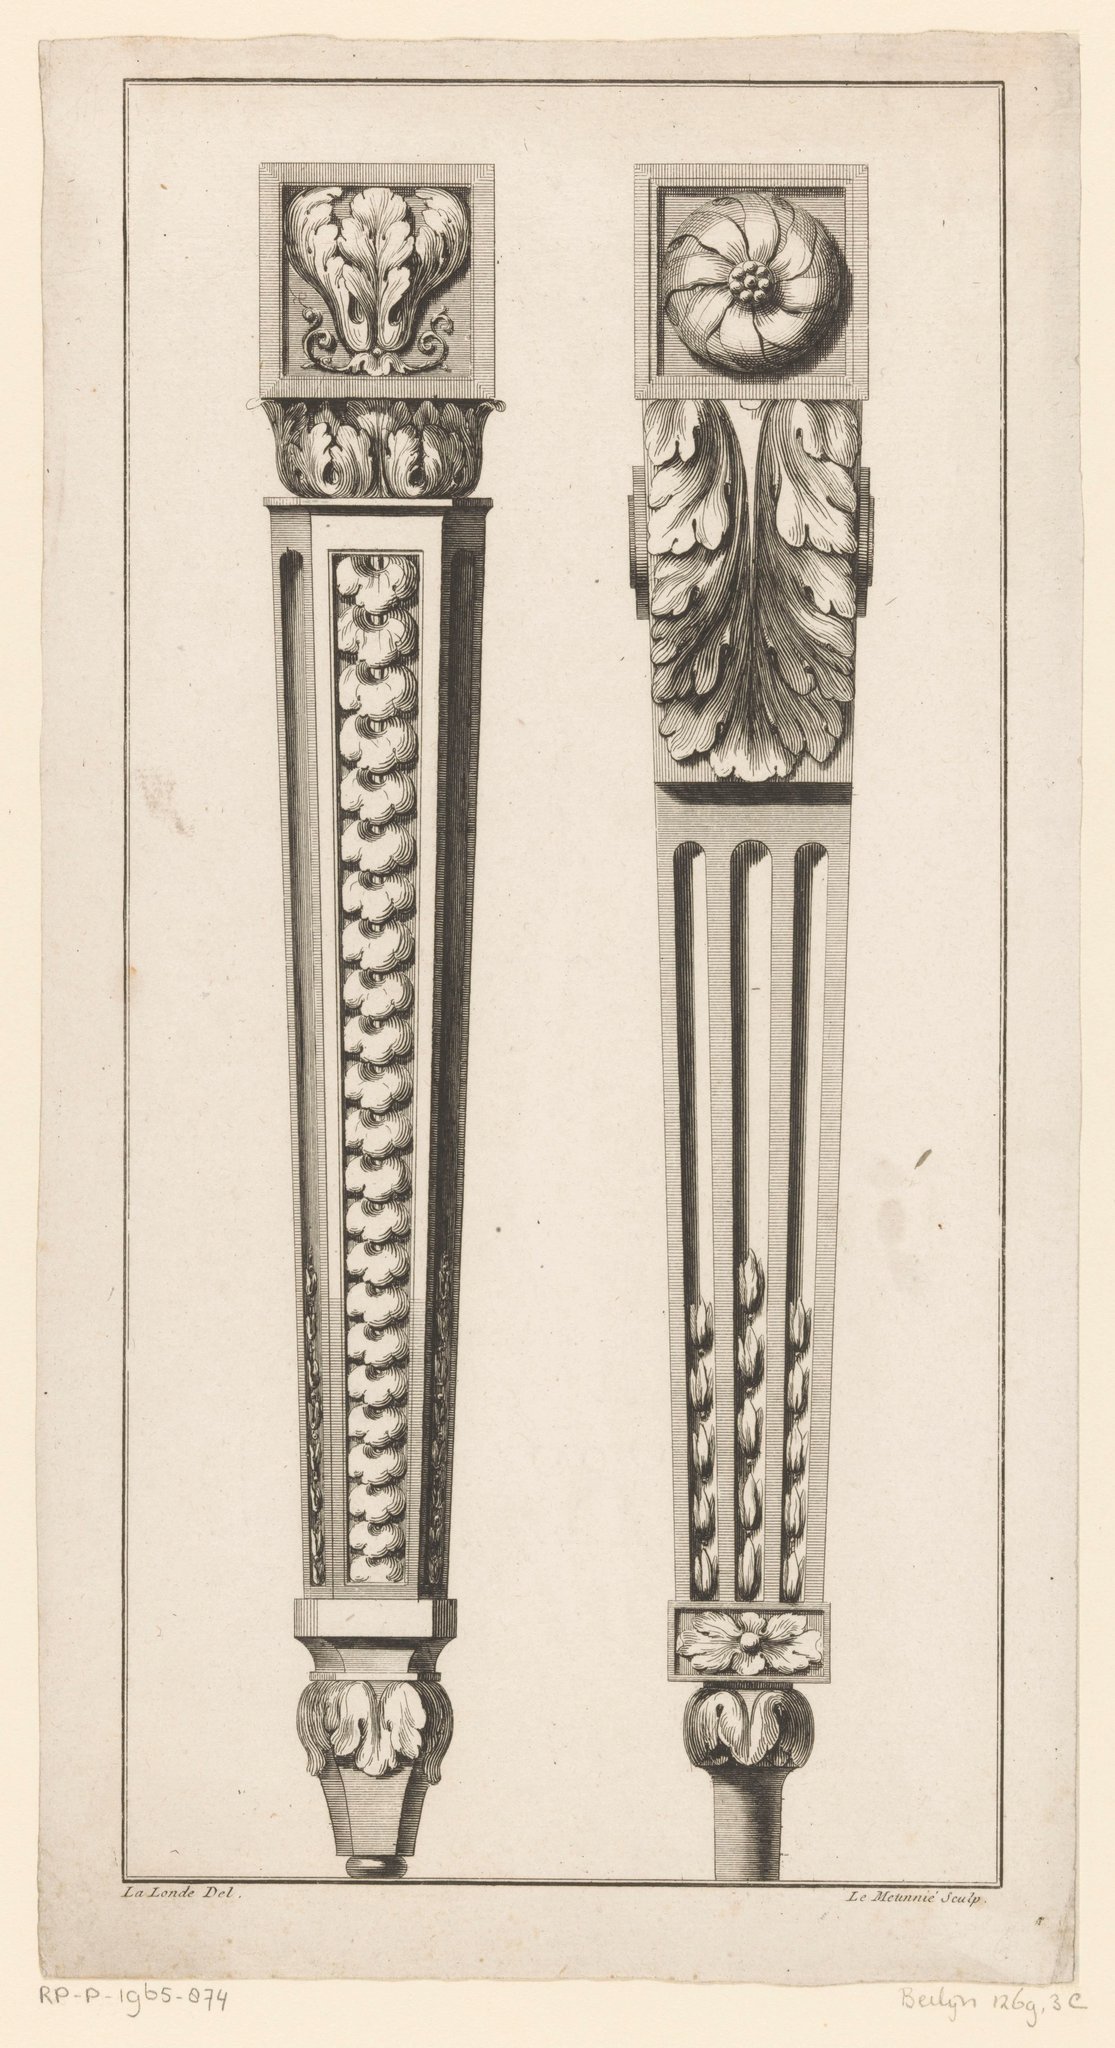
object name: print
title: C Cahier de Pieds de Meubles à divers usages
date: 1784-1785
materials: paper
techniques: engraving, etching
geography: paris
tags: ornaments ~ art (+ framing decorations)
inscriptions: collector's mark: Lugt 2228, collector's mark: Lugt 2760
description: Twee geornamenteerde meubelpoten met bladmotieven.